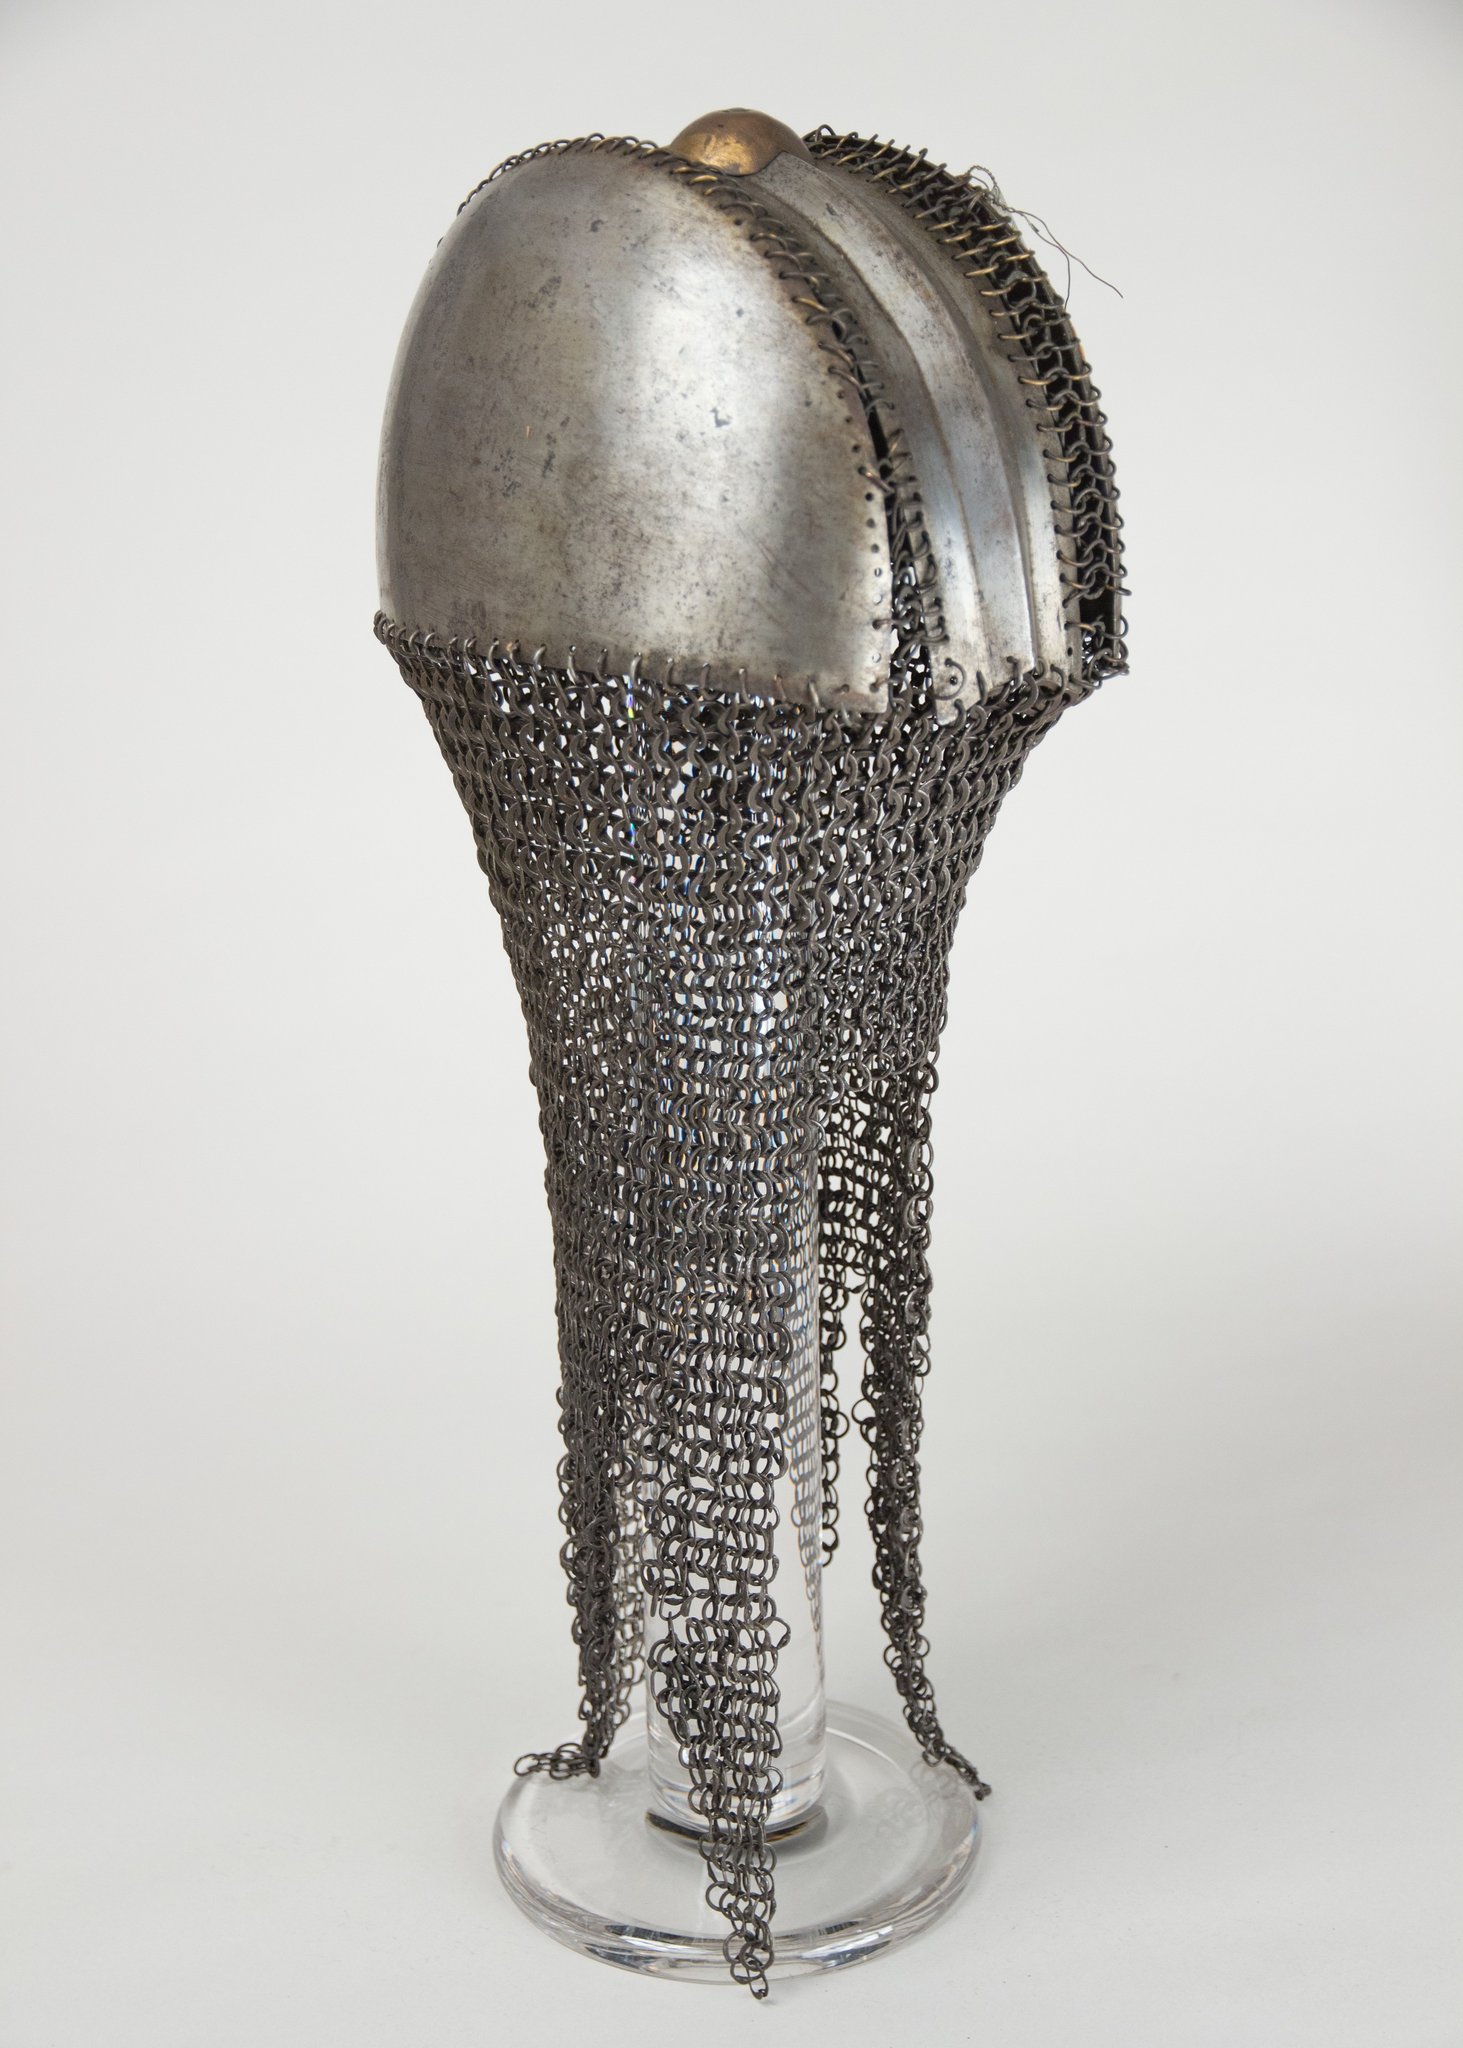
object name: helmet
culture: indian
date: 1701-1900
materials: iron, steel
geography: india